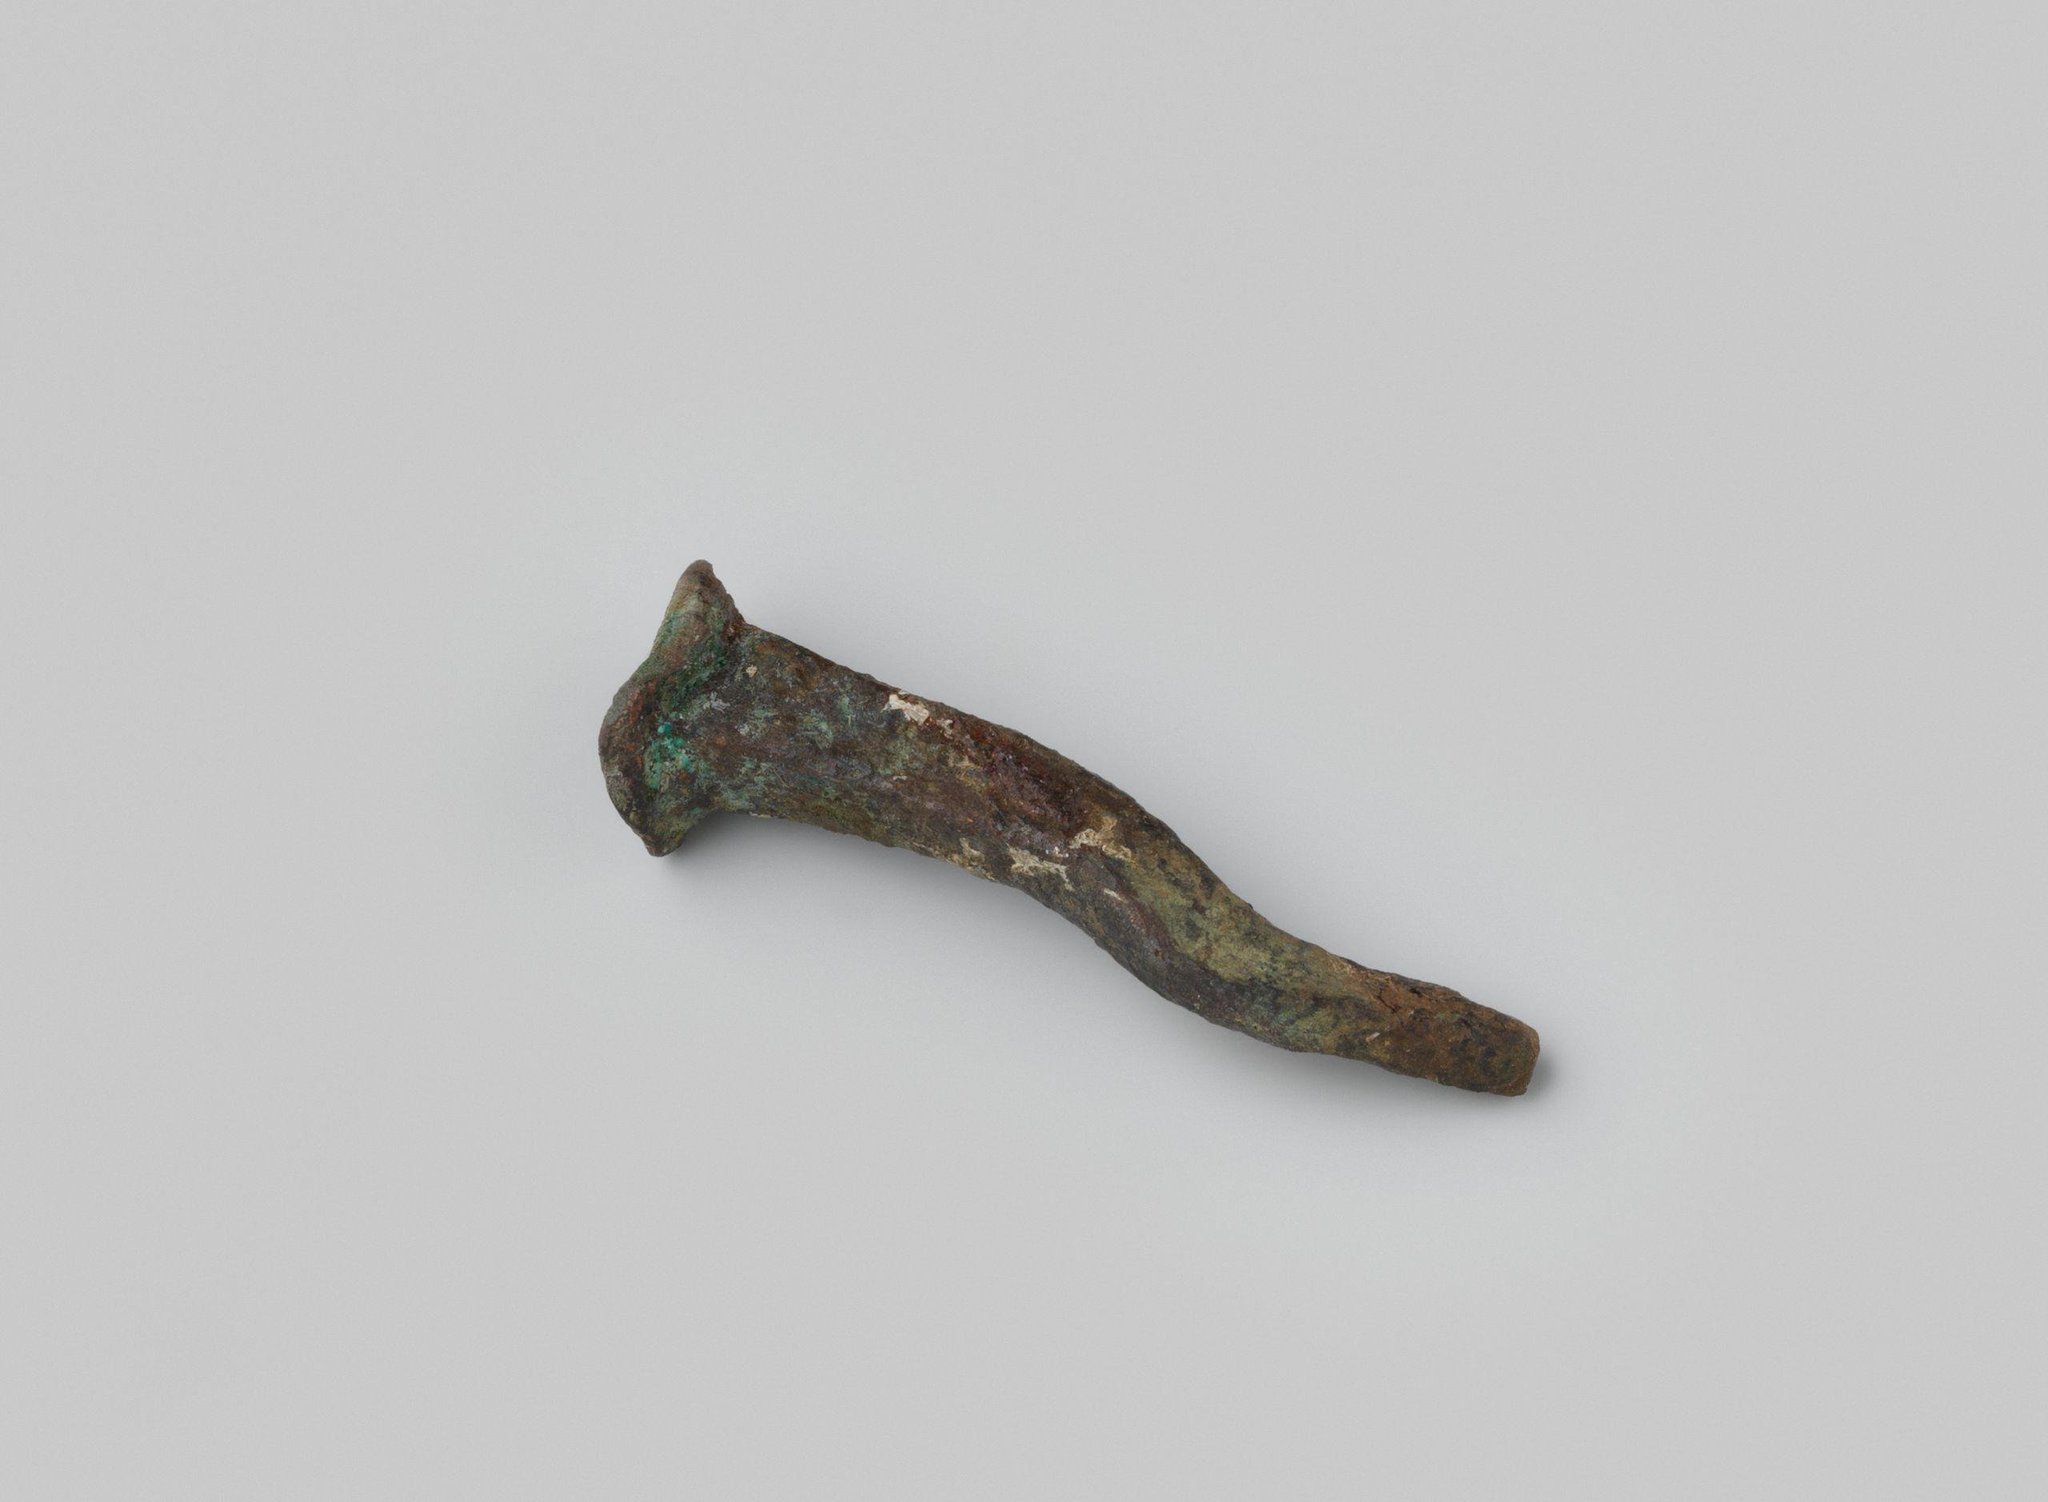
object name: nagel, spijker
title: Spijker afkomstig uit het wrak van de Oost-Indiëvaarder Hollandia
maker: Anonymous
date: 1700-1743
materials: iron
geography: netherlands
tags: verenigde oostindische compagnie, hollandia (schip)